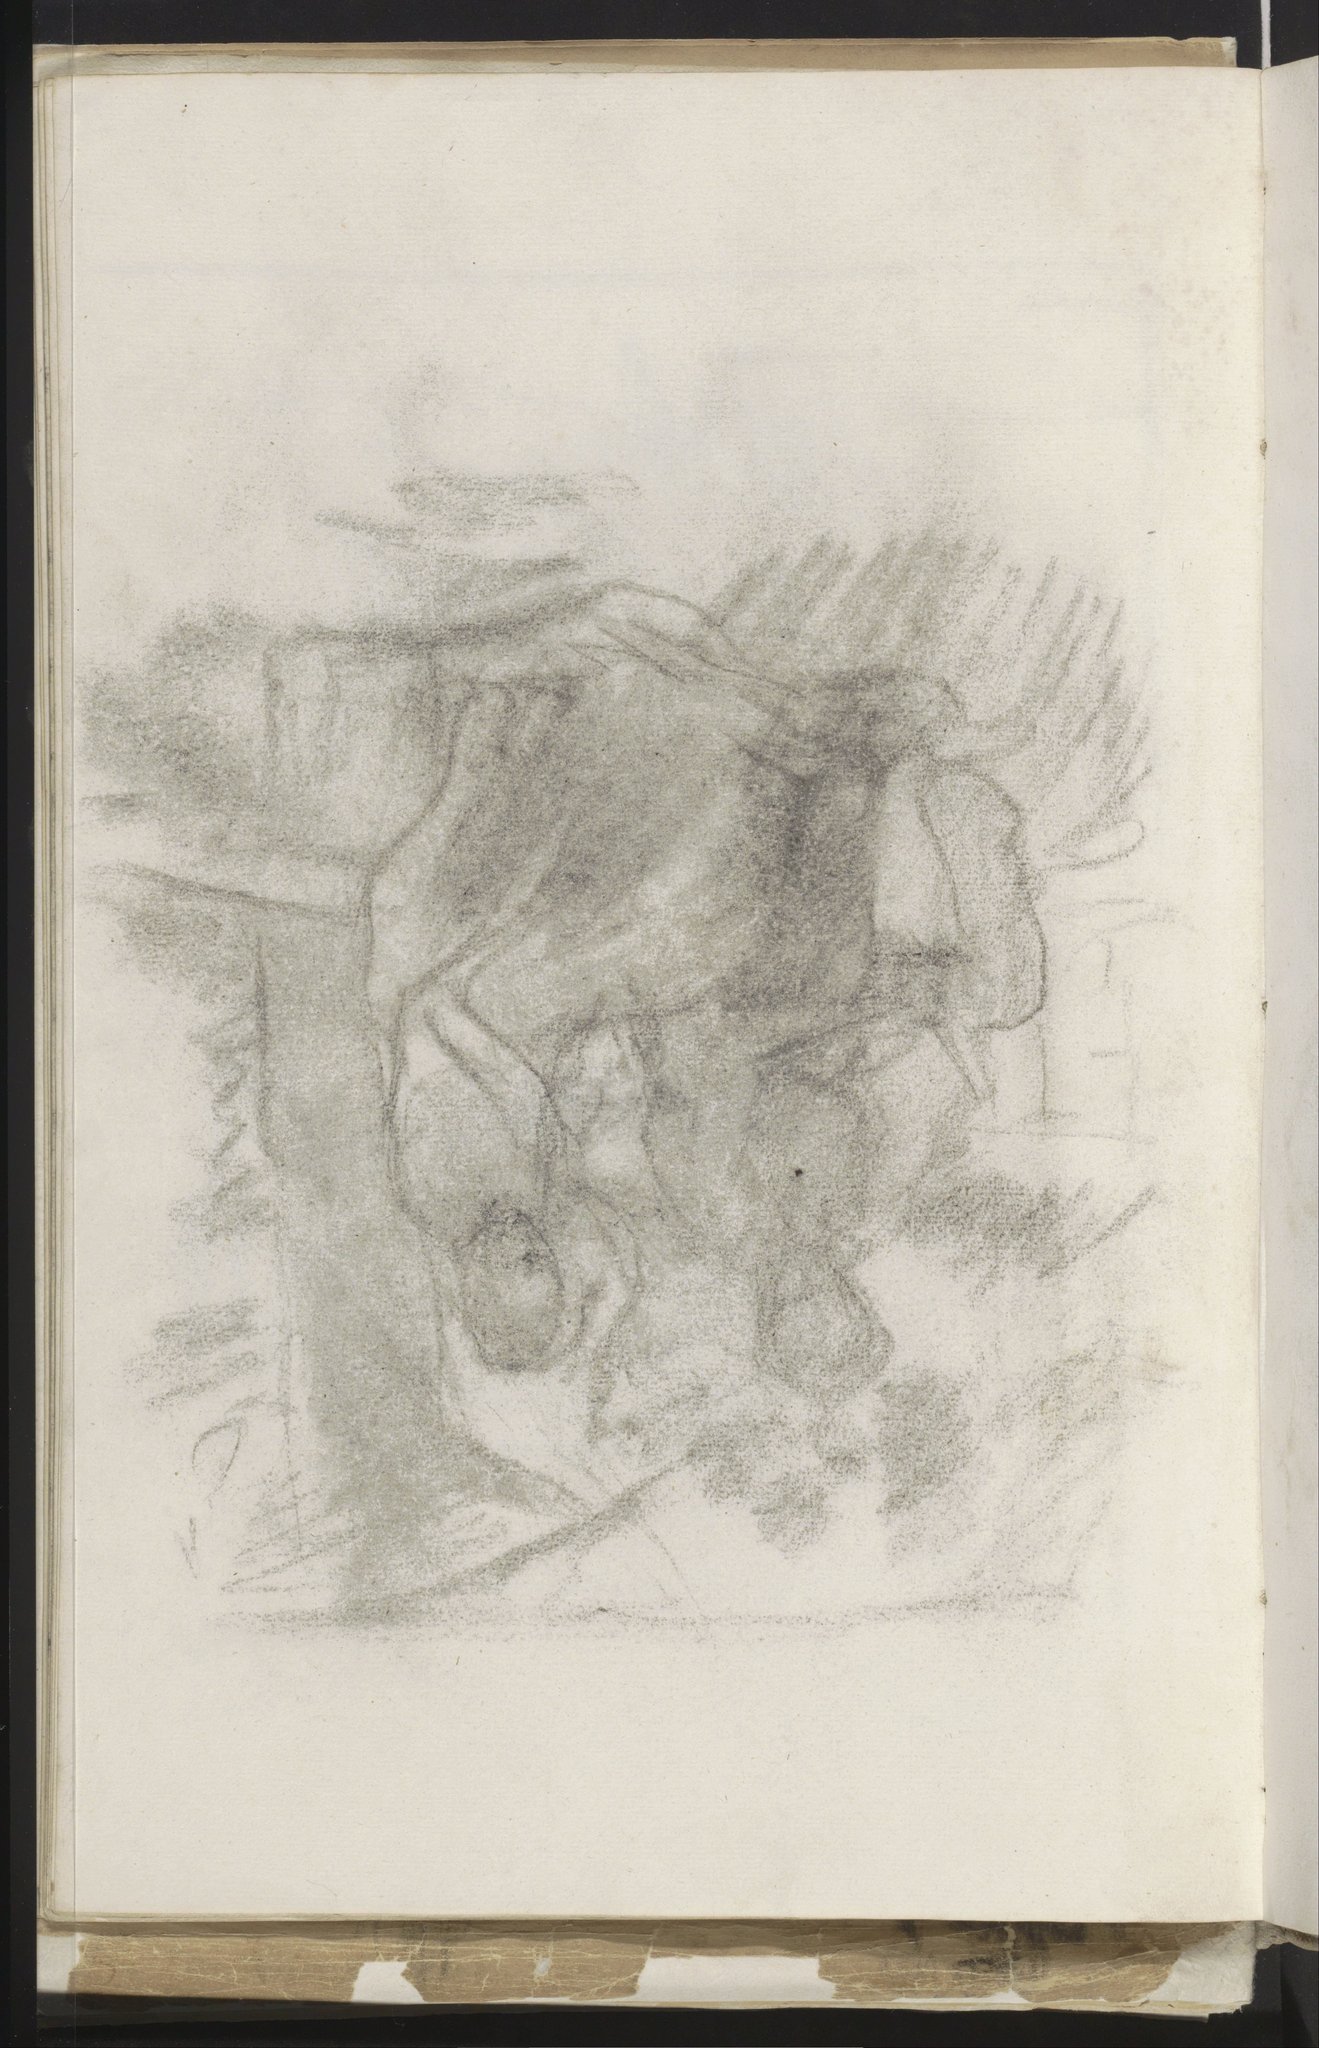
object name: sketchbook leaf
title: Liefdespaar op een bank bij een boom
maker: albert neuhuys (1844-1914)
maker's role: draughtsman, painter, print maker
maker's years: 1844-1914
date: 1854-1914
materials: charcoal, paper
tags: bench, trees, home sewing; repair of clothes, lovers; courting, flirting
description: De vrouw is aan het handwerken terwijl de man toekijkt. Blad 44 verso uit een schetsboek met 53 bladen.